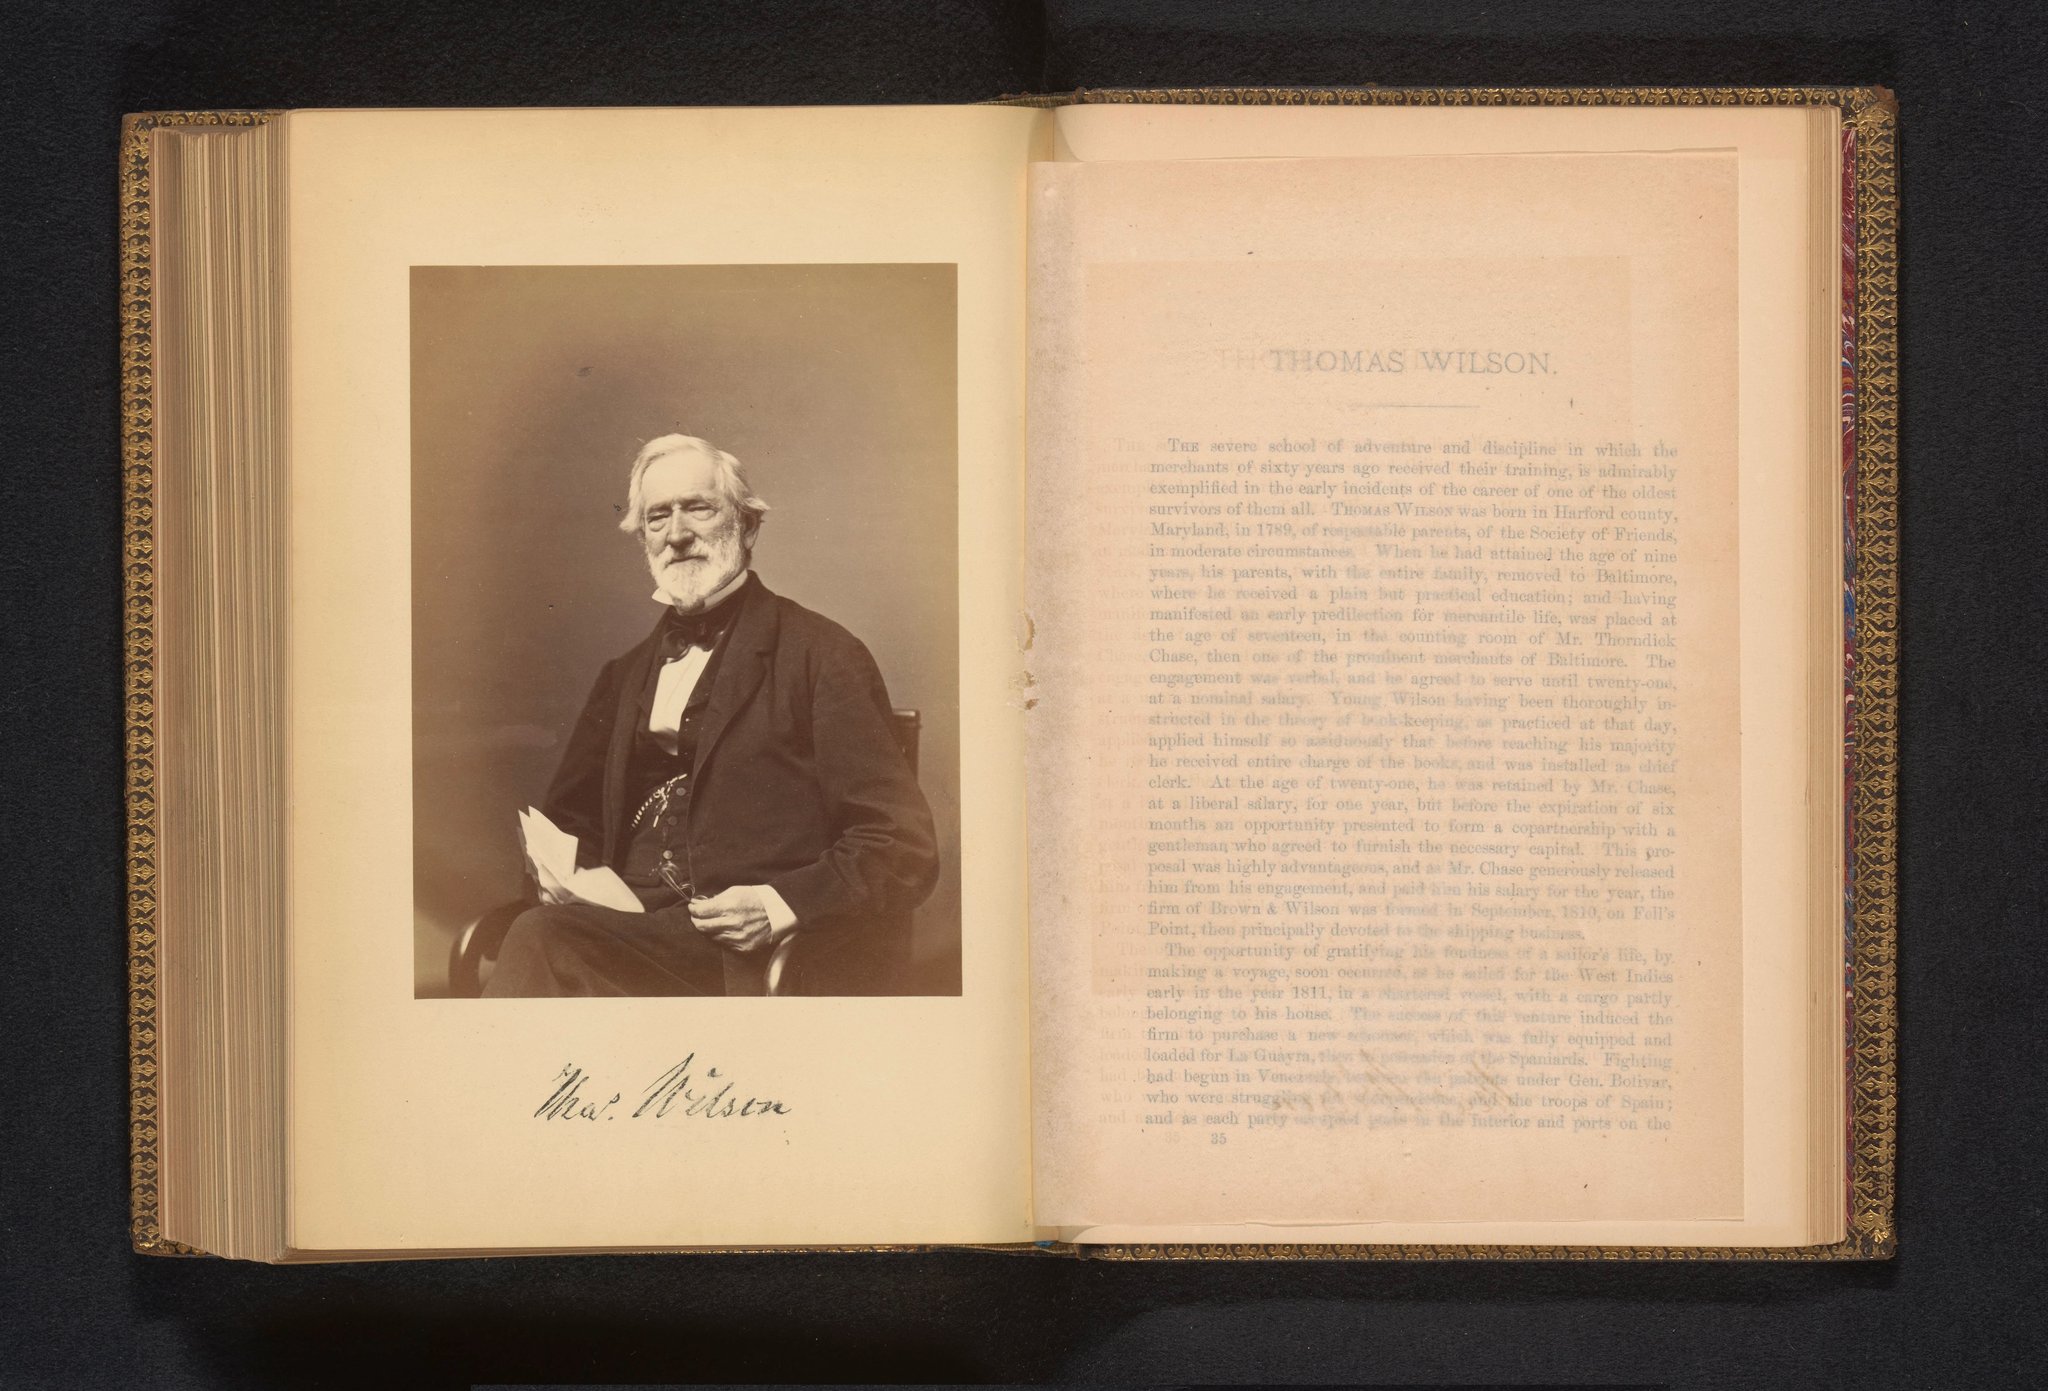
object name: page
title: Portret van Thomas Wilson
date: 1866-1871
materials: photographic support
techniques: albumen print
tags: historical persons